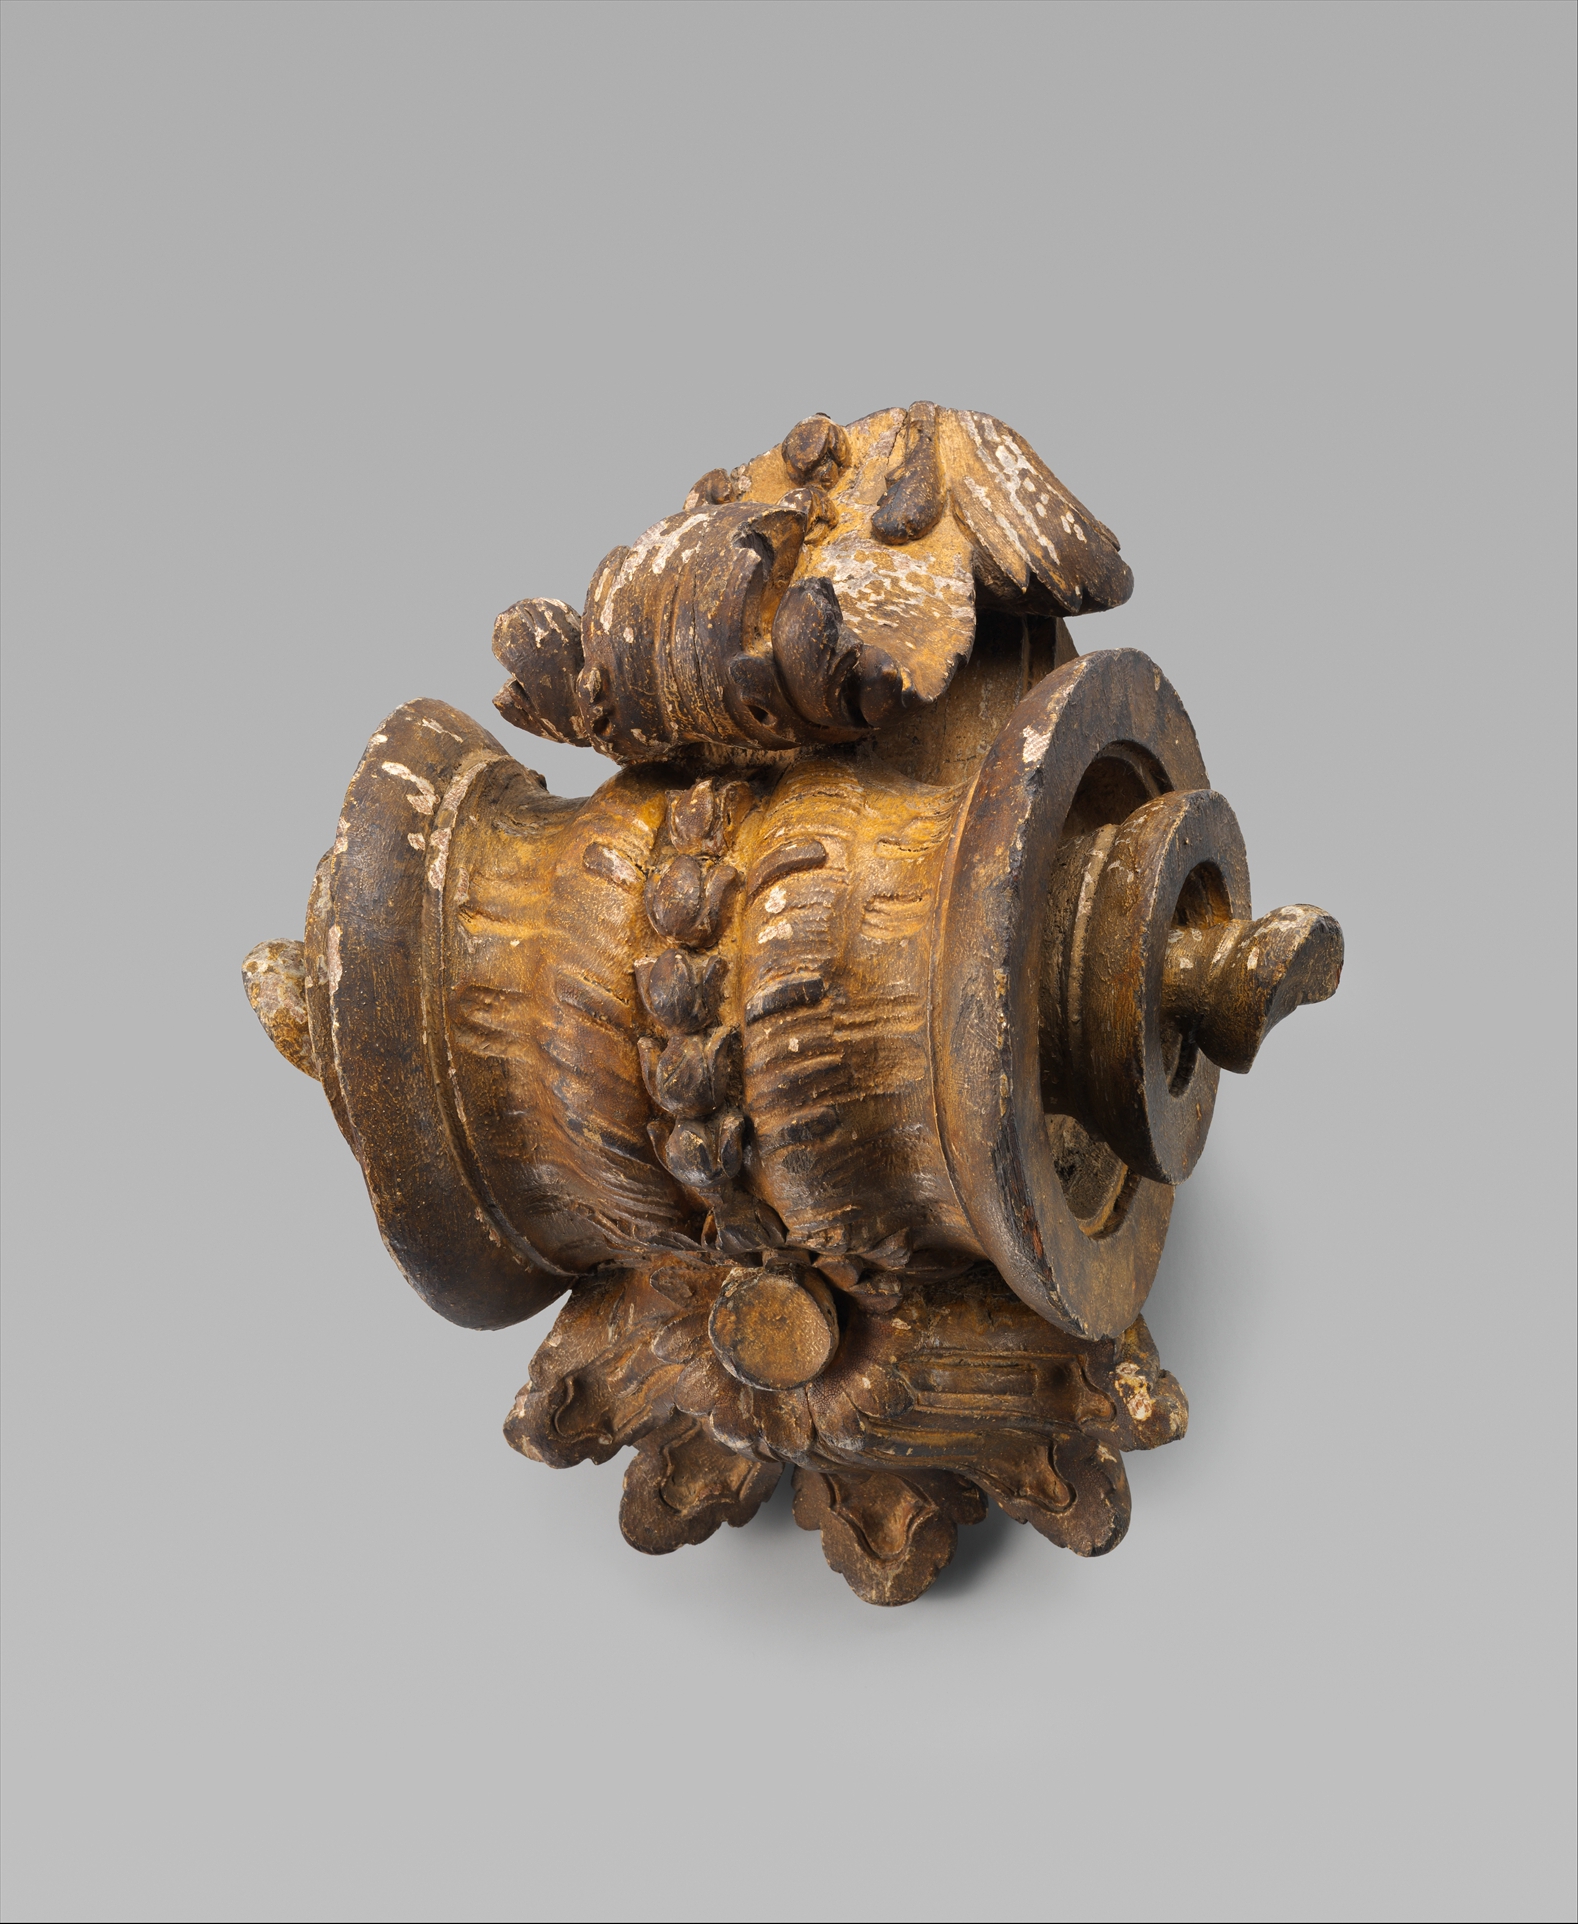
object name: console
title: Part of a console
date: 1667-1700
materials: wood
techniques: carving, painting